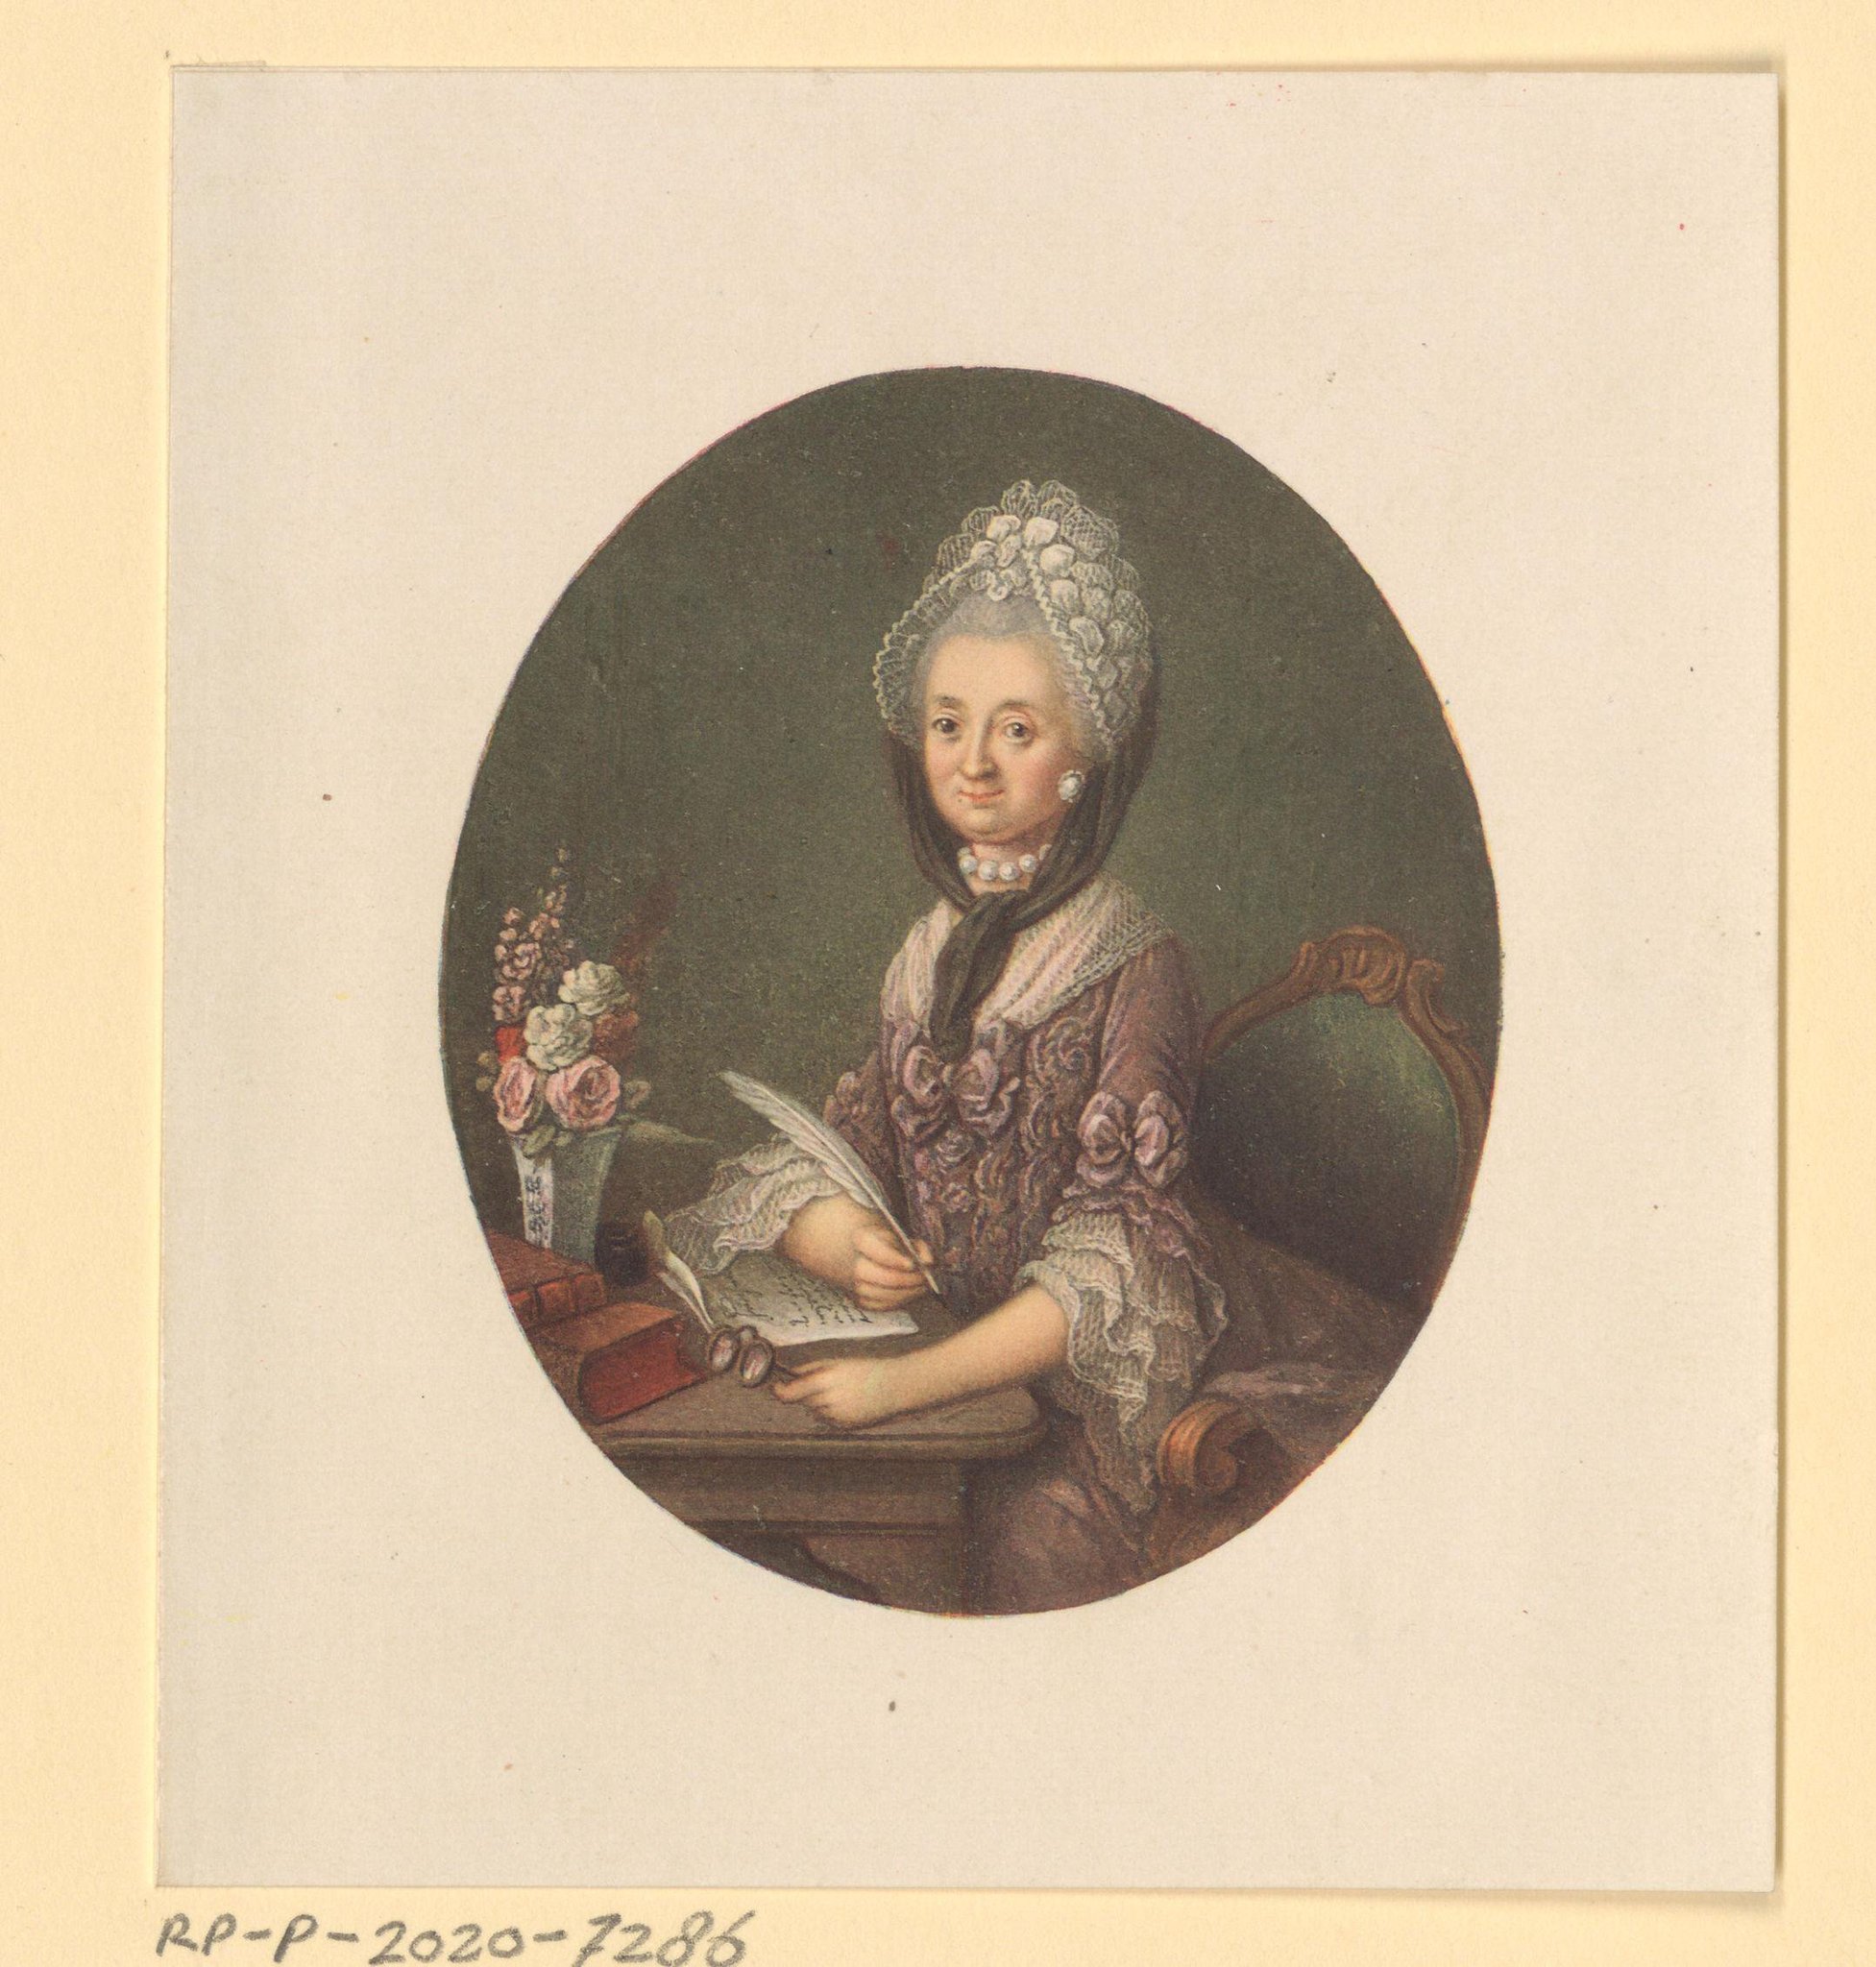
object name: photomechanical print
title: Portret van Elisabeth Charlotte Jacobi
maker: Anonymous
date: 1912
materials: paper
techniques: collotype process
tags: historical persons - bb - woman, house personnel, servants